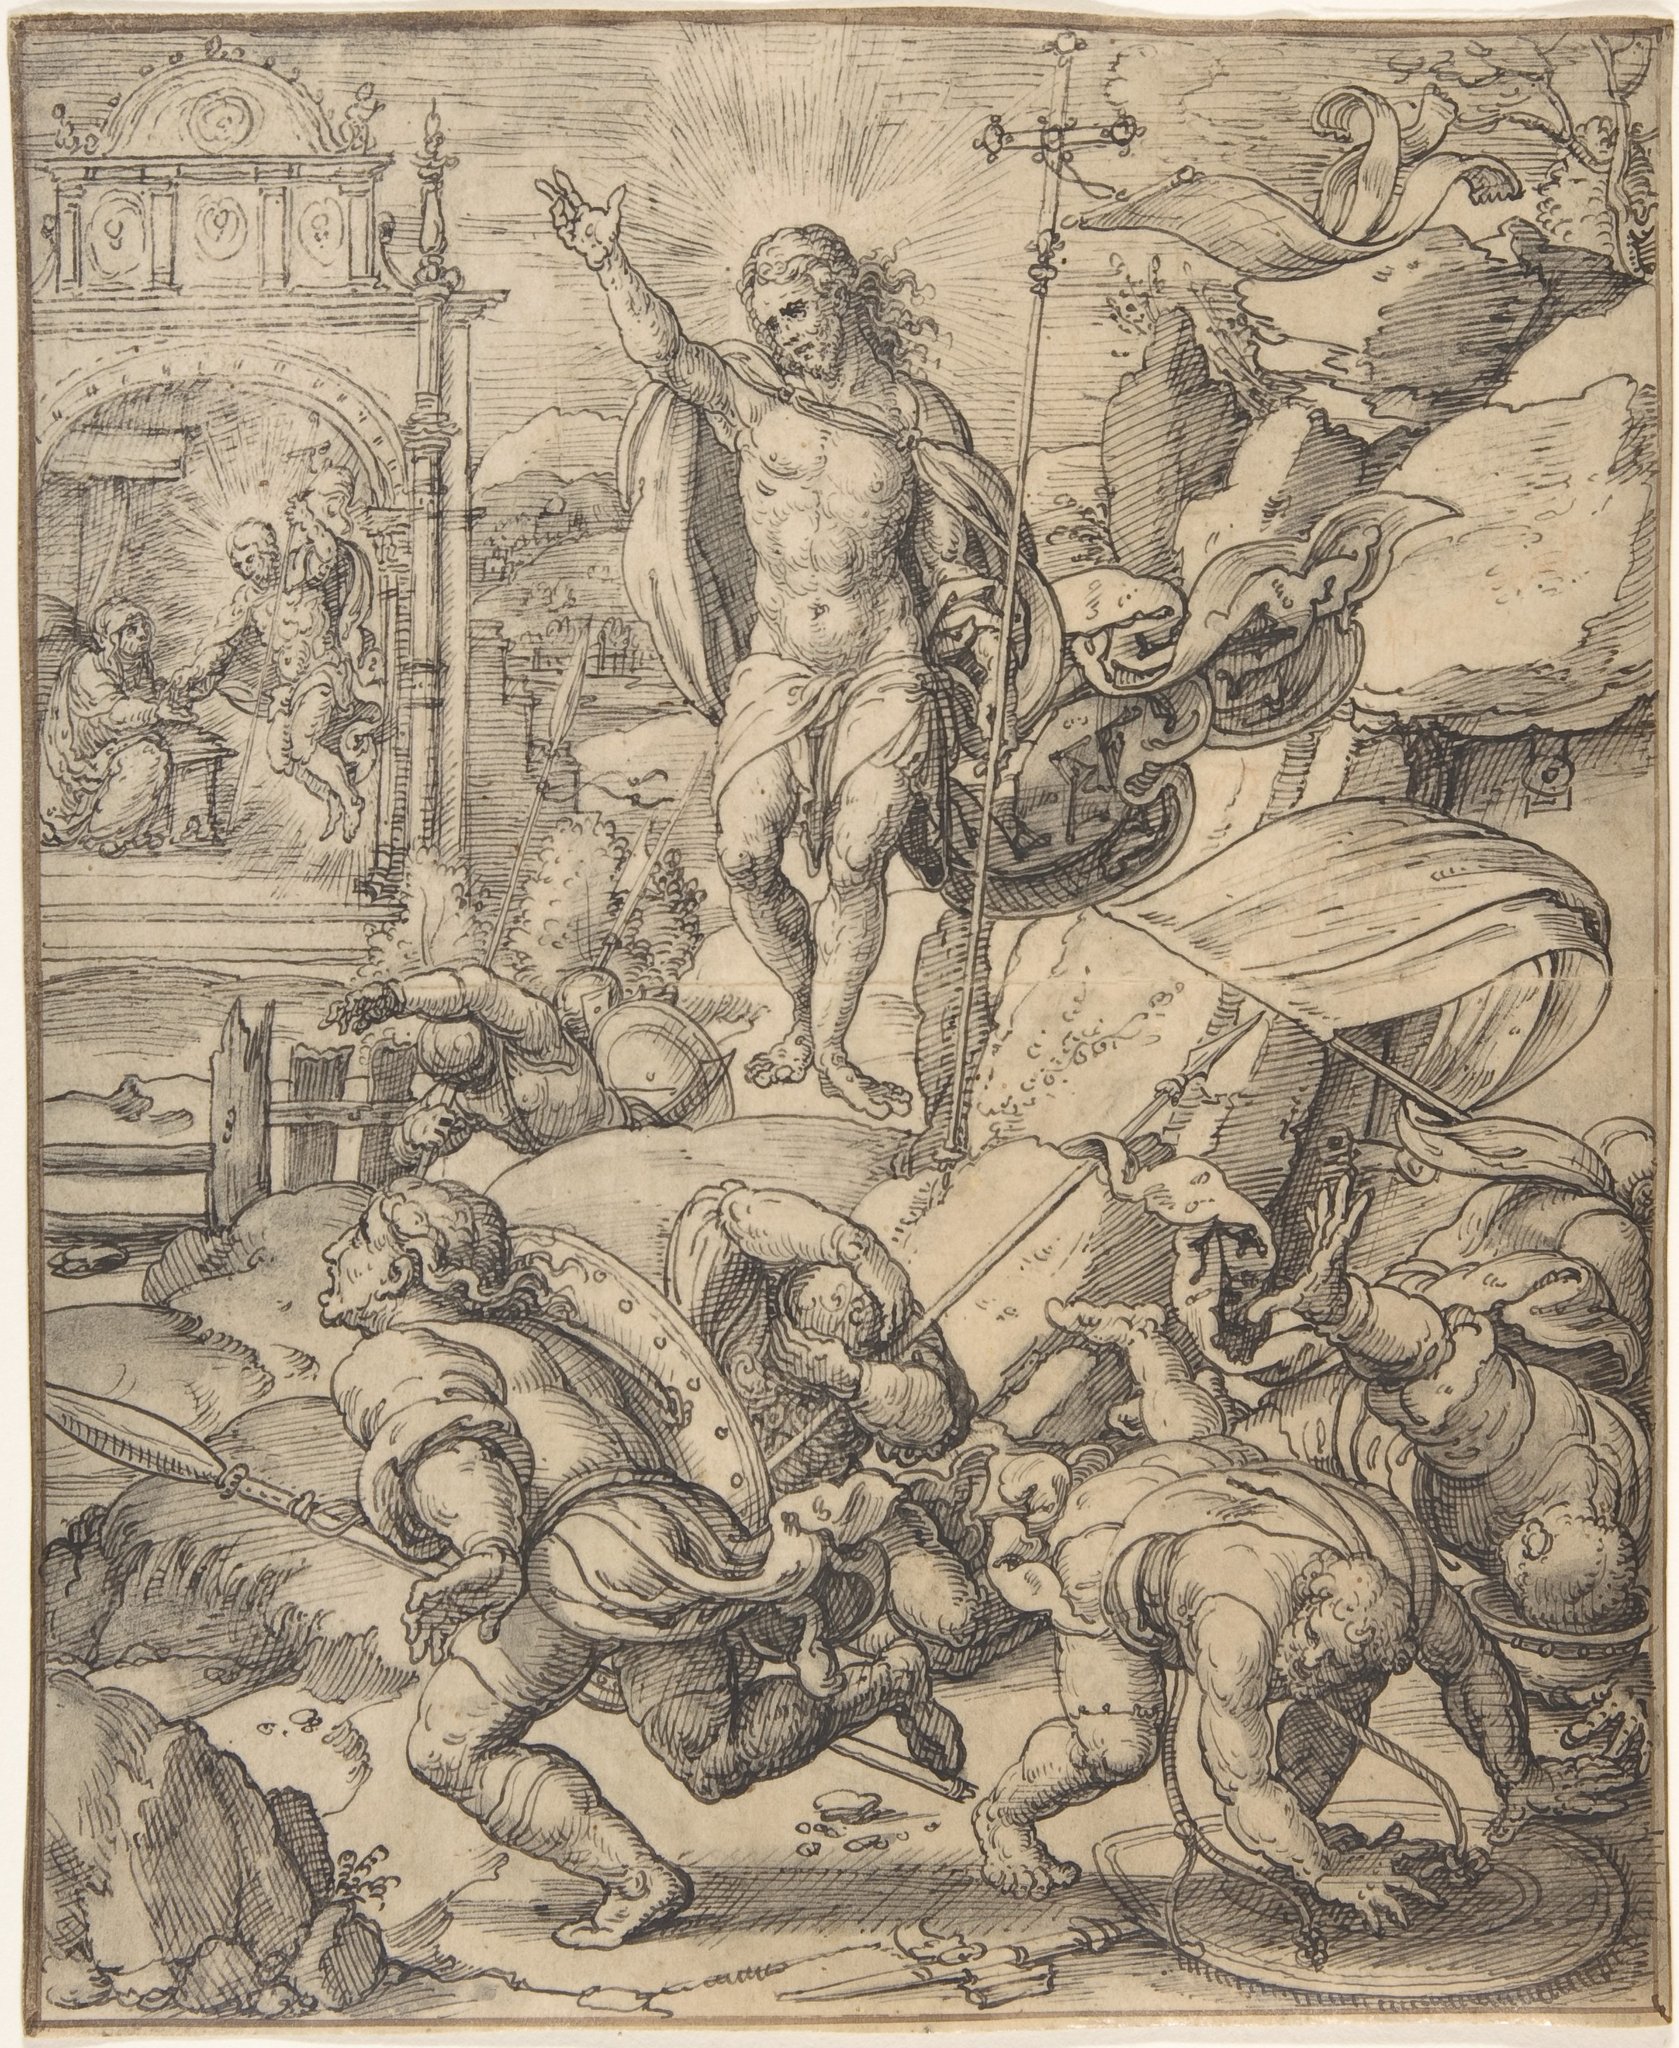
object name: drawing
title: The Resurrection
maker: bernard van orley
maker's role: artist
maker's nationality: netherlandish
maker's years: 1492-1542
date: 1501-1533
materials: ink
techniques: pen, wash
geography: belgium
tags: soldiers,christ,cross